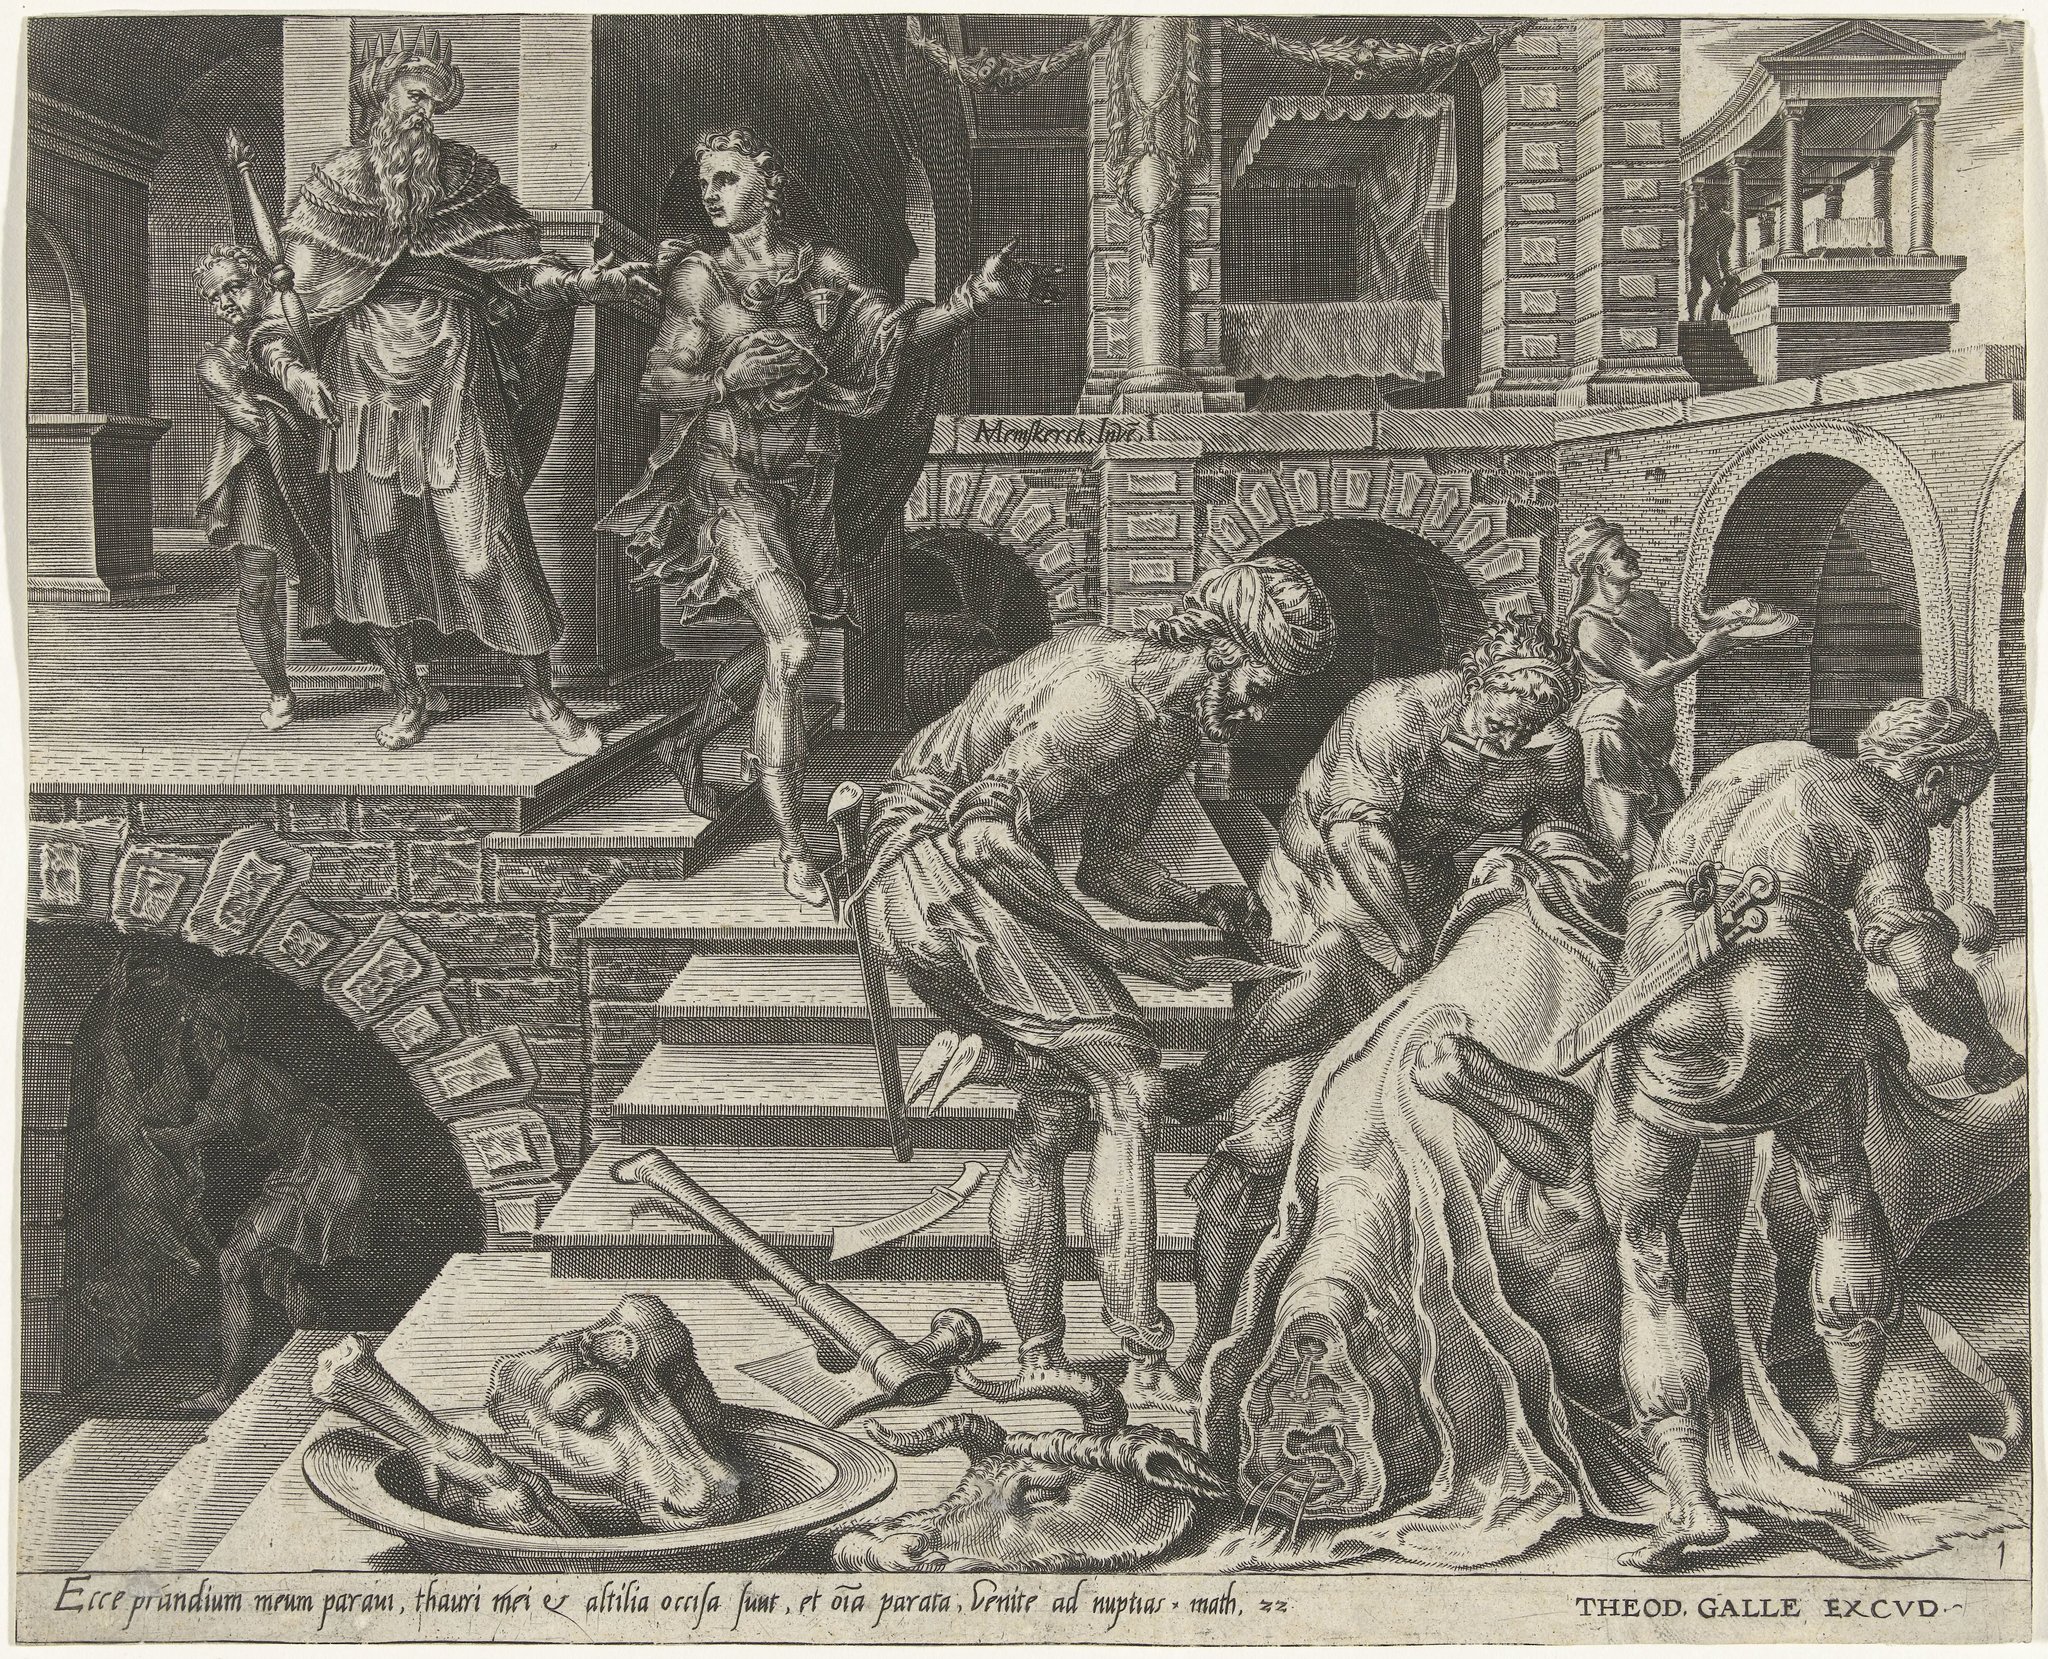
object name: print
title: Gelijkenis van een bruiloftsfeest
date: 1558-1559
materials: paper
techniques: engraving, etching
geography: haarlem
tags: first invitation to the feast ~ parable of the royal wedding-feast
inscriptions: collector's mark: Lugt 2228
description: De voorbereidingen voor het banket. De koning heeft zijn beste mestvee laten slachten. Hij stuurt zijn dienaren erop uit om de gasten uit te nodigen. Bovenaan de prent een cartouche met een Latijnse tekst. De prent heeft tevens een Latijns onderschrift en maakt deel uit van een zesdelige serie over de gelijkenis van een bruiloftsfeest.